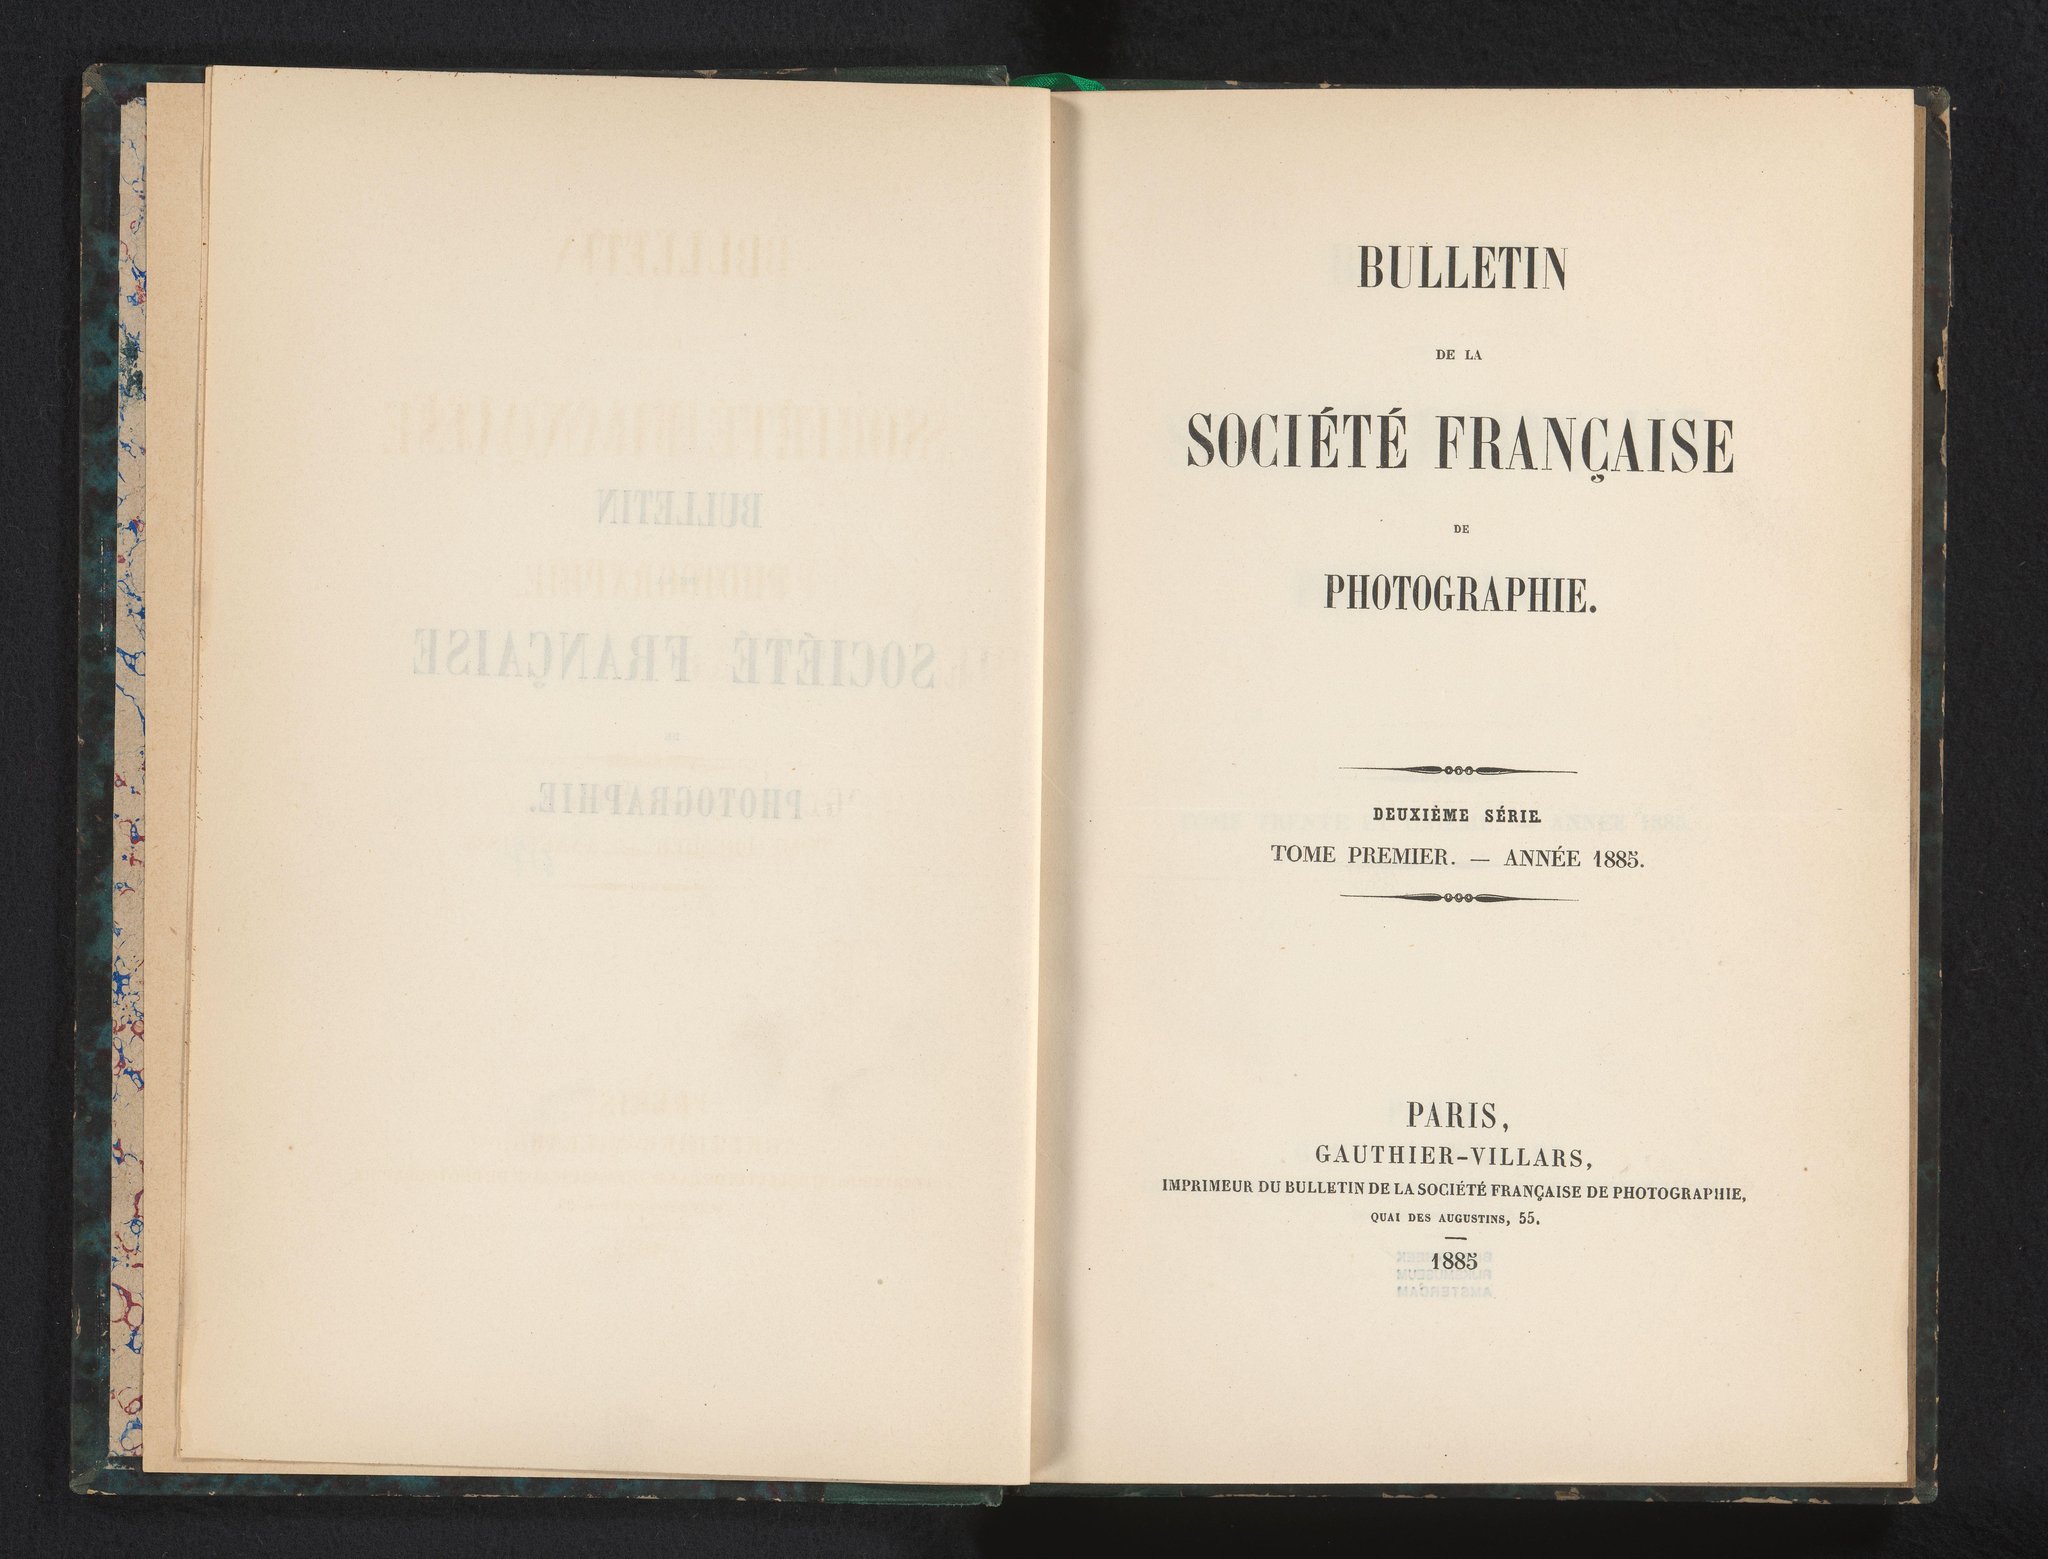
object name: book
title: Bulletin de la Société française de photographie. Tome trente et unième - année 1885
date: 1885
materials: paper, cardboard, leather, textile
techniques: photograph, letterpress printing, marbling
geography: paris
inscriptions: number: ‘617’